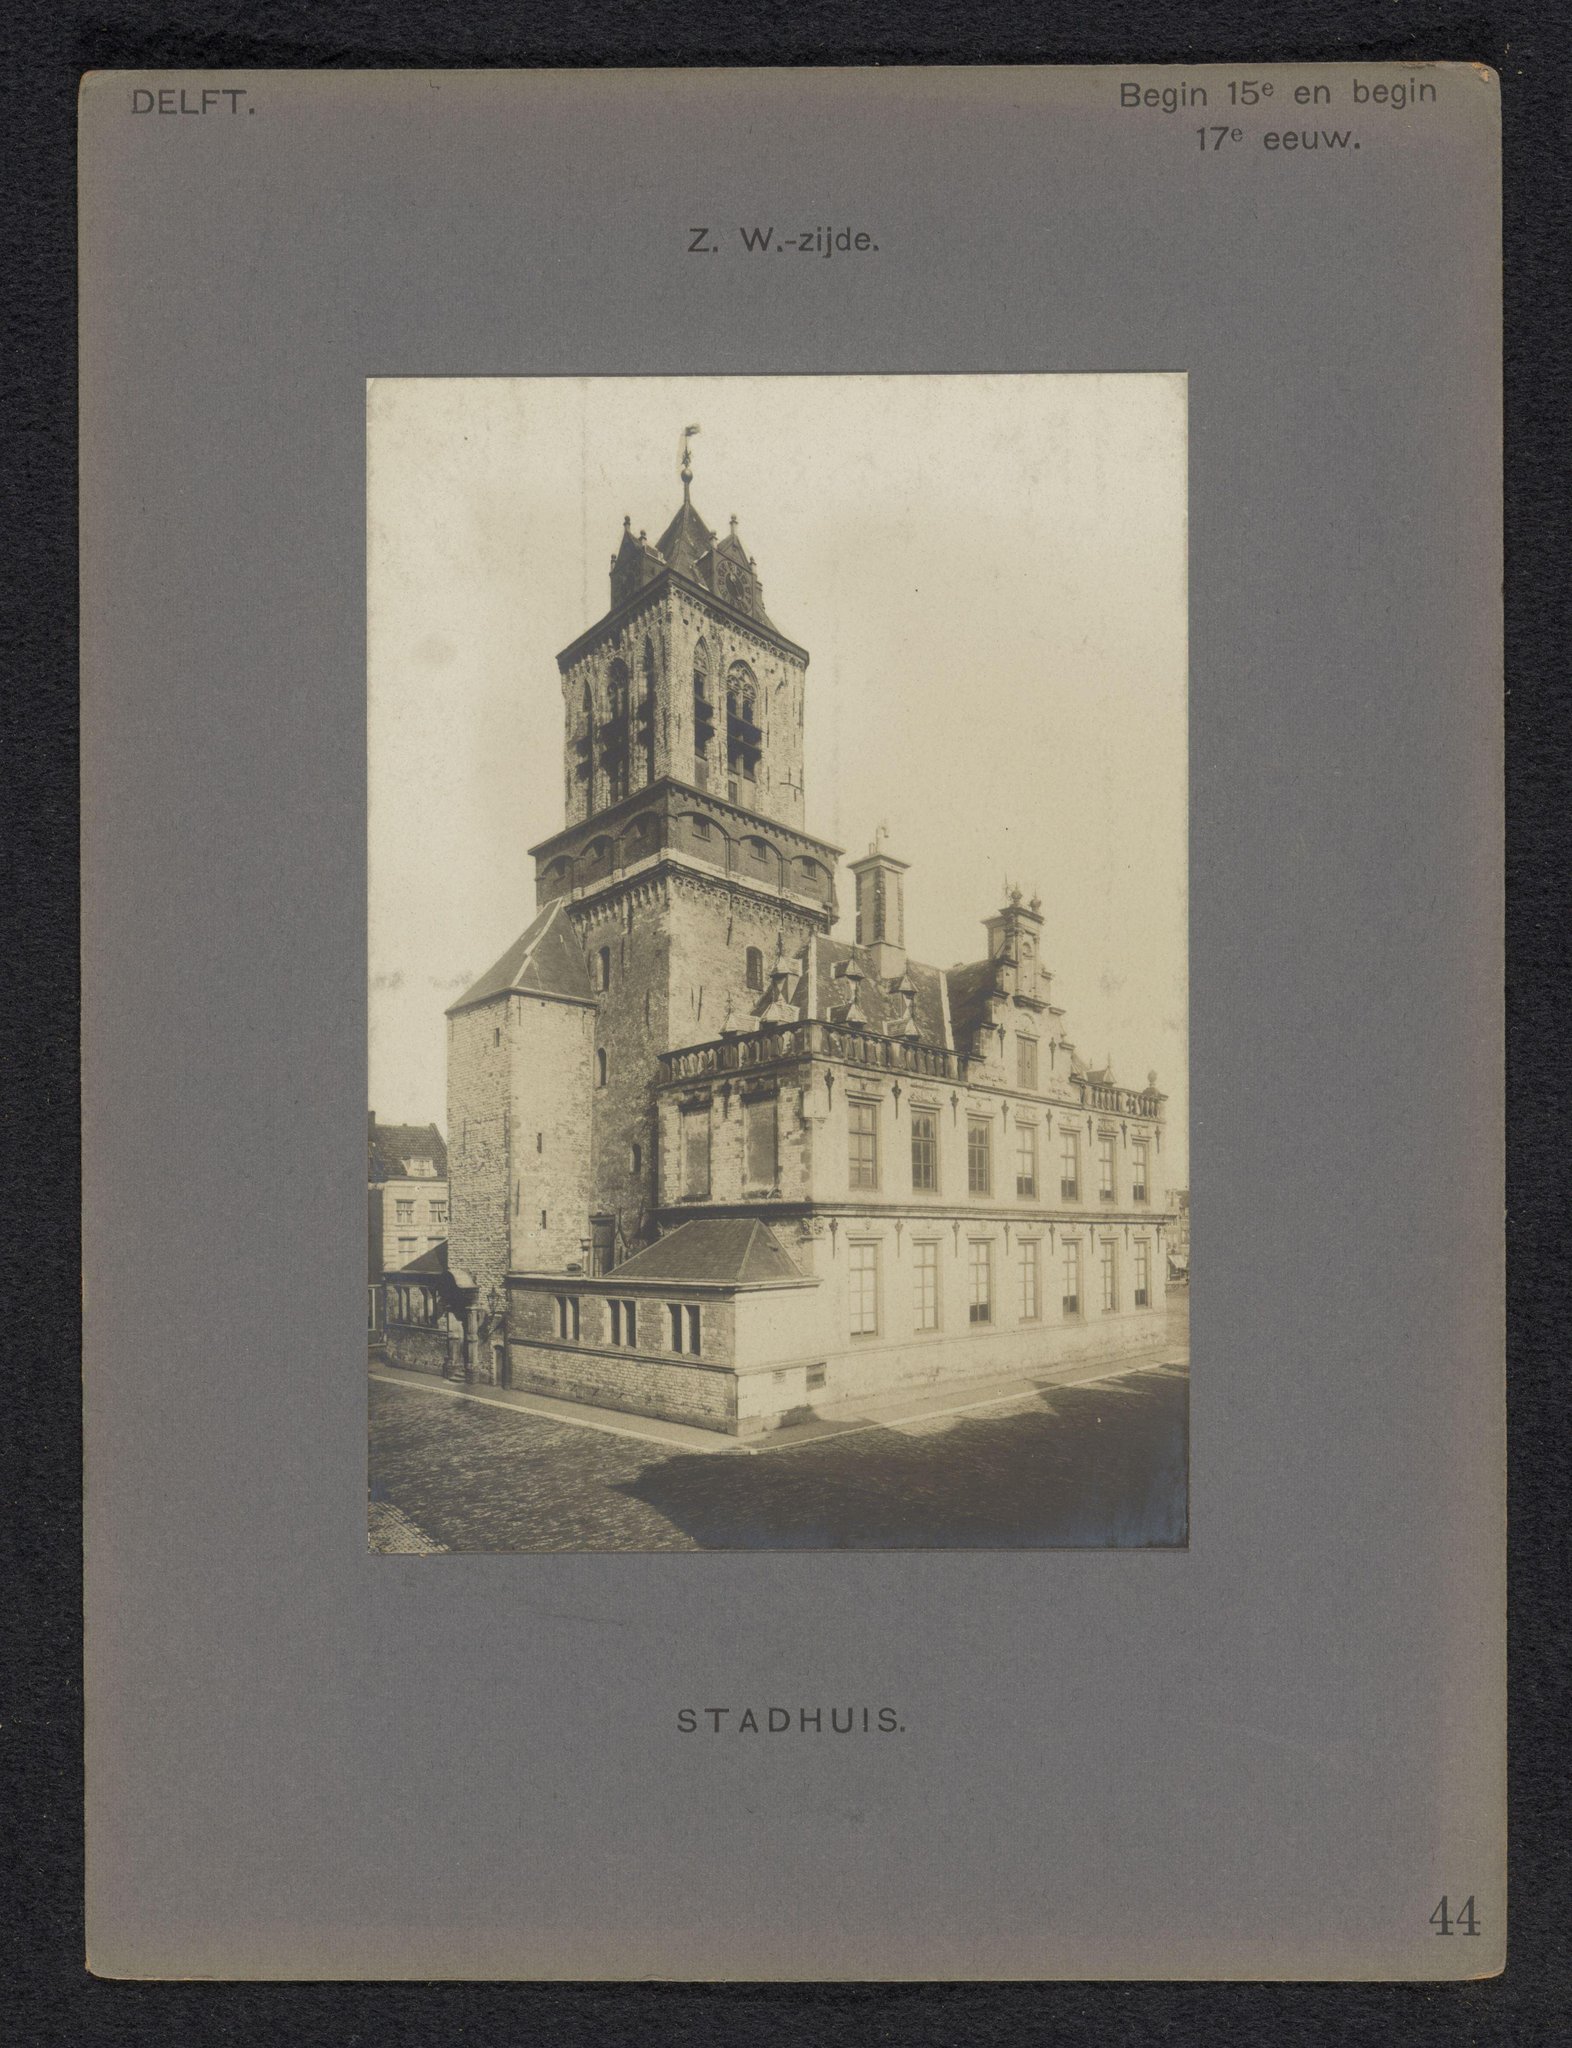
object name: photograph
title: Stadhuis. Z.W.-zijde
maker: Anonymous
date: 1900-1904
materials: cardboard, photographic support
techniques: gelatin silver print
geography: delft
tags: townhall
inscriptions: inscription: ‘Het recht van reproductie dezer photo's wordt door den Uitgever voorbehouden.’, number: ‘44’, inscription: ‘Delft. Begin 15e en begin 17e eeuw.’